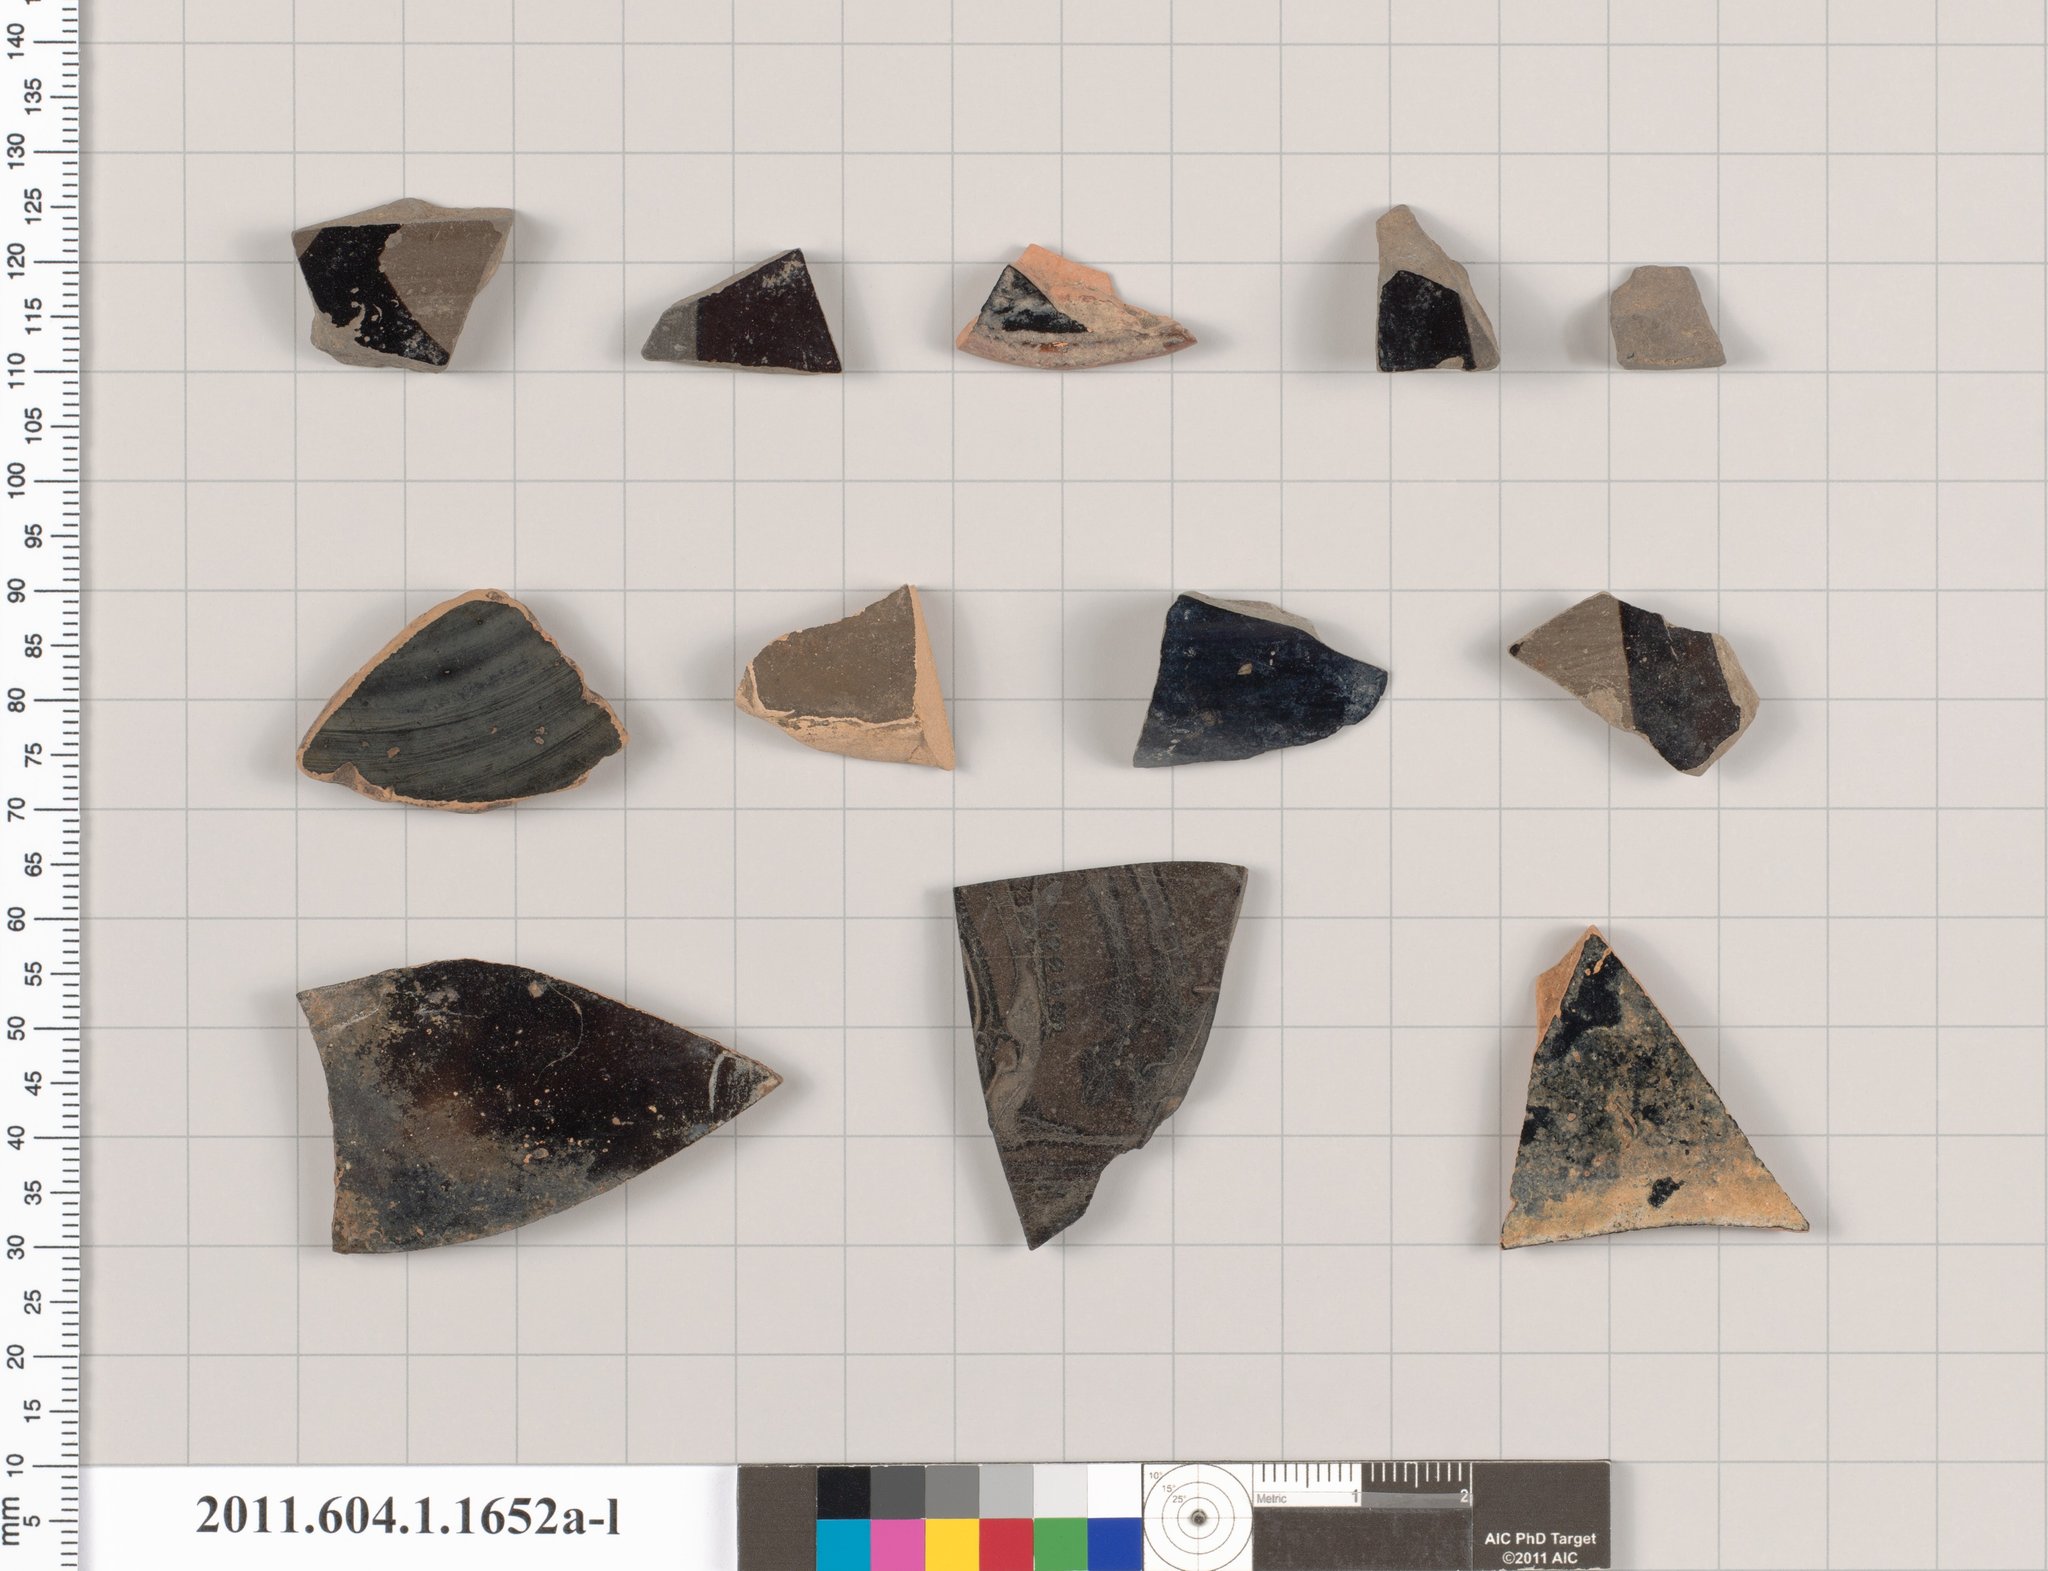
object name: kylix fragment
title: Terracotta fragments of kylikes (drinking cups)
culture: greek, attic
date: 500-401 BCE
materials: terracotta